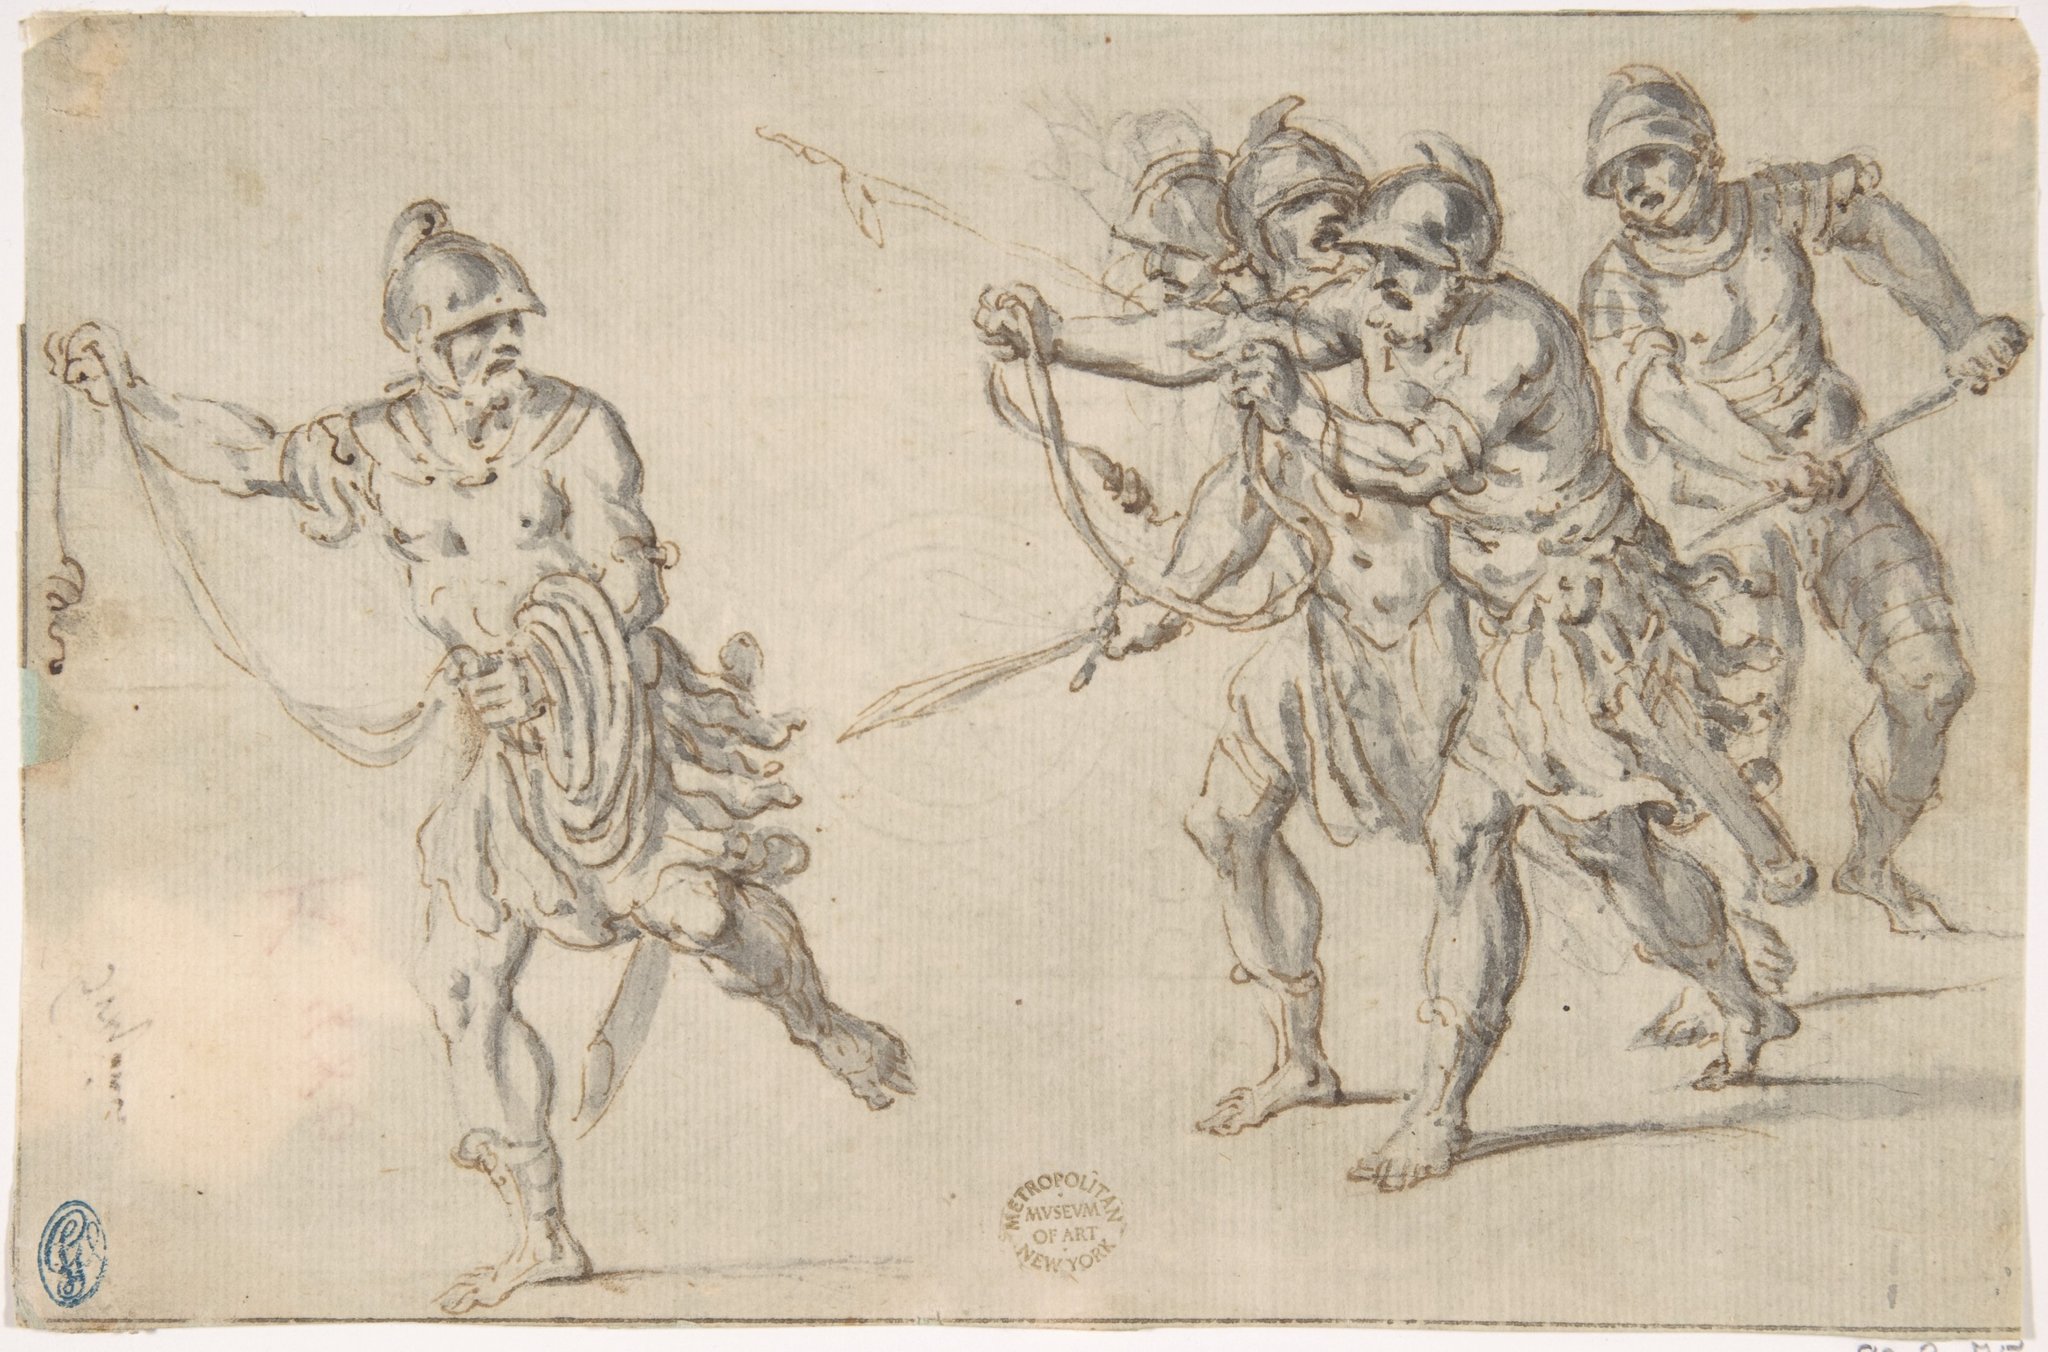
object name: drawing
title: Soldiers Running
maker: anonymous, italian, 16th century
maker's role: artist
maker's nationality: italian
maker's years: 1550-1600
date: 1501-1600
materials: chalk, ink, paper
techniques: brush, pen, wash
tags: soldiers,swords,men,running